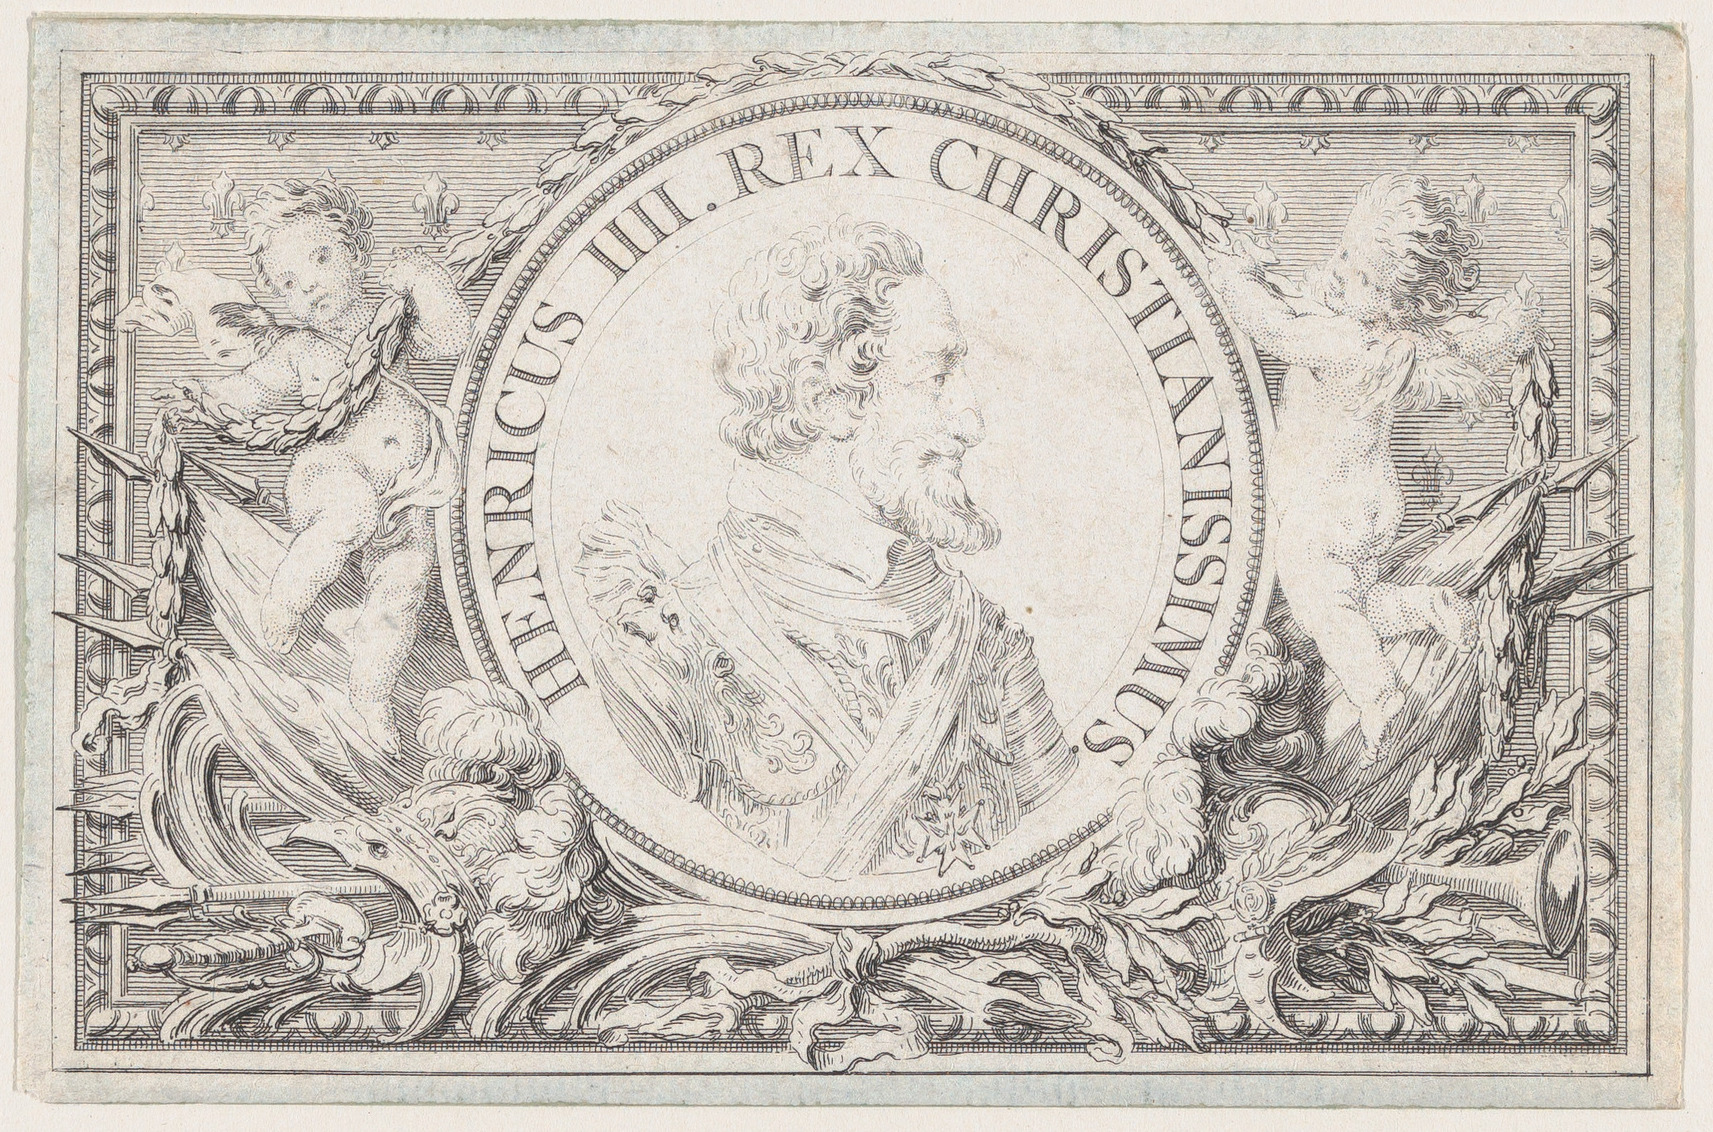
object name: print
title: Portrait of Henry IV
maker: pierre philippe choffard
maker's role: artist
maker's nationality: french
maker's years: 1730-1809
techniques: etching, stippling